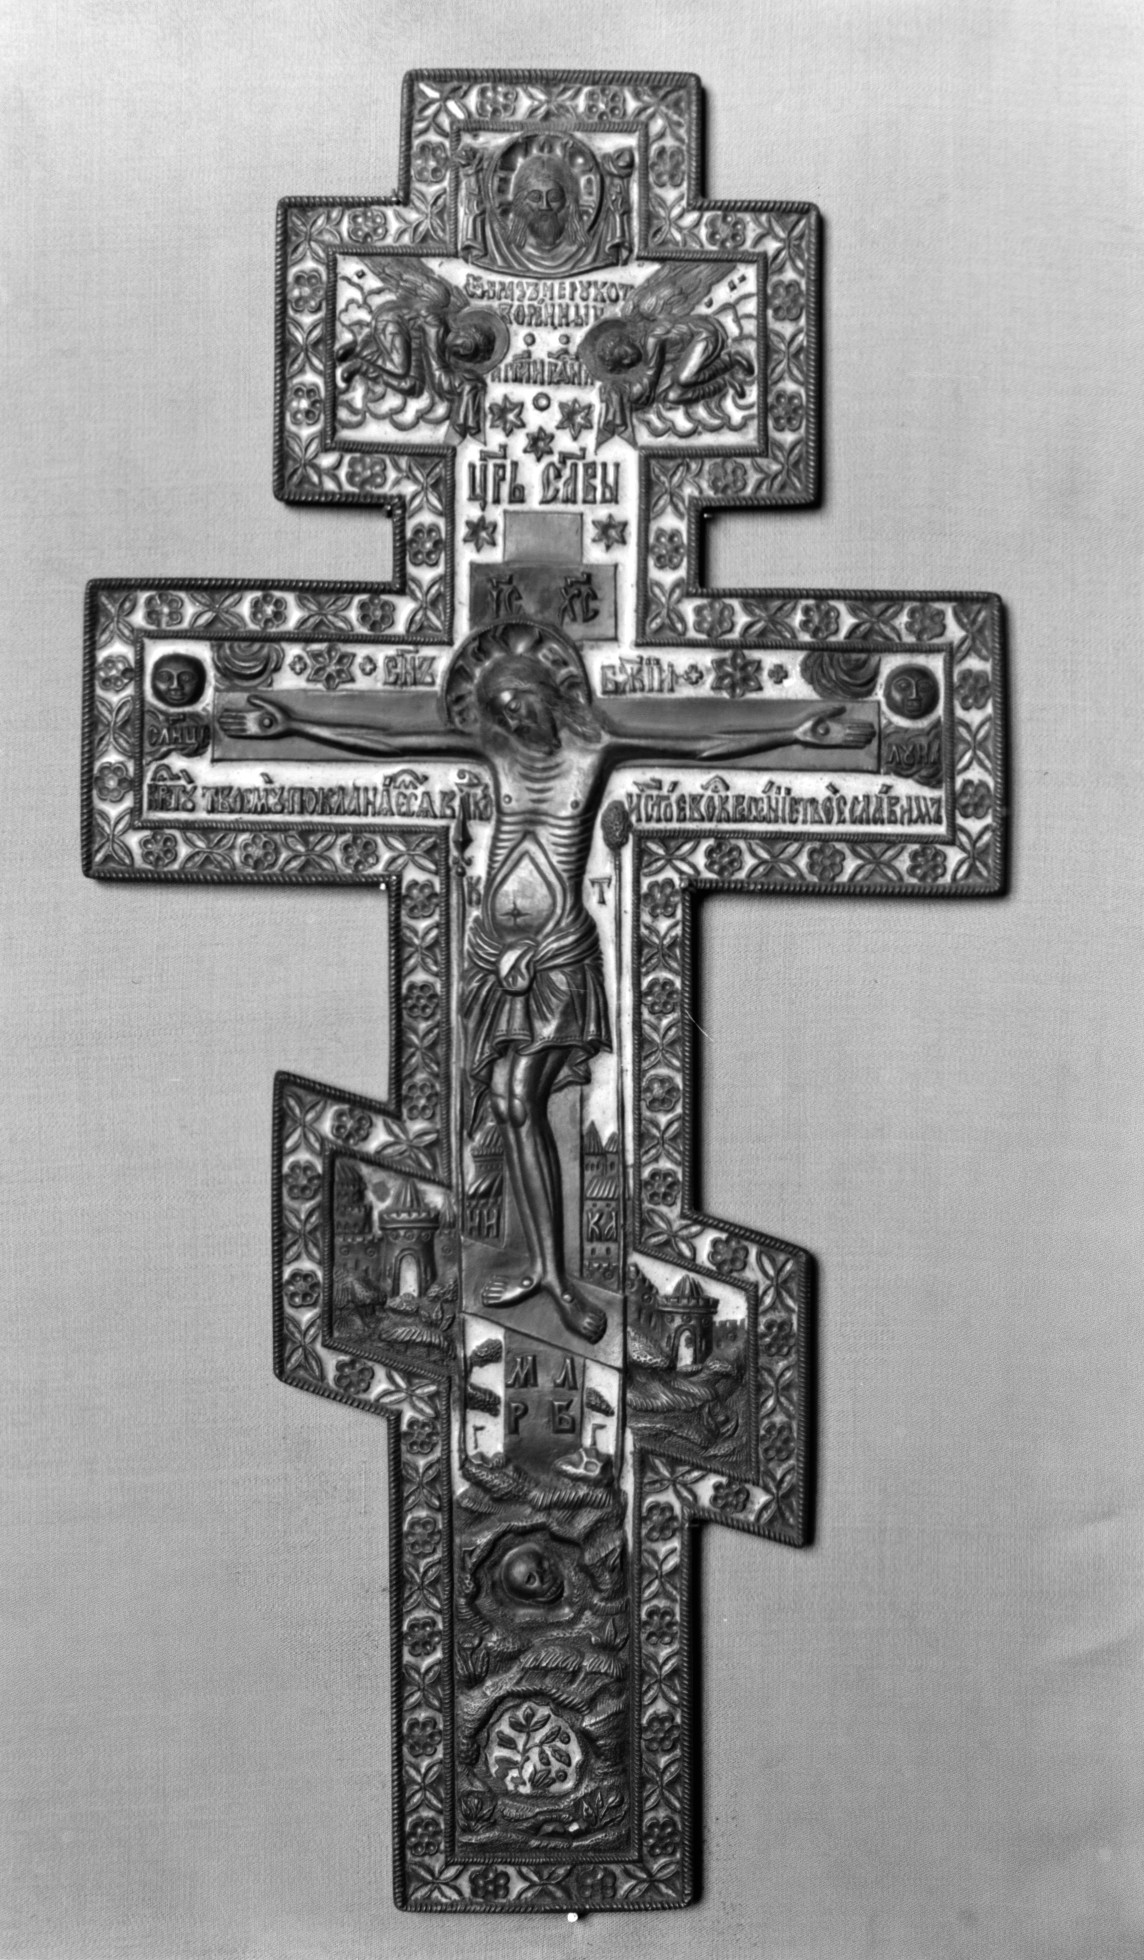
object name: crucifix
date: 1801-1900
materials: brass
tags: faces,angels,christ,crucifixion